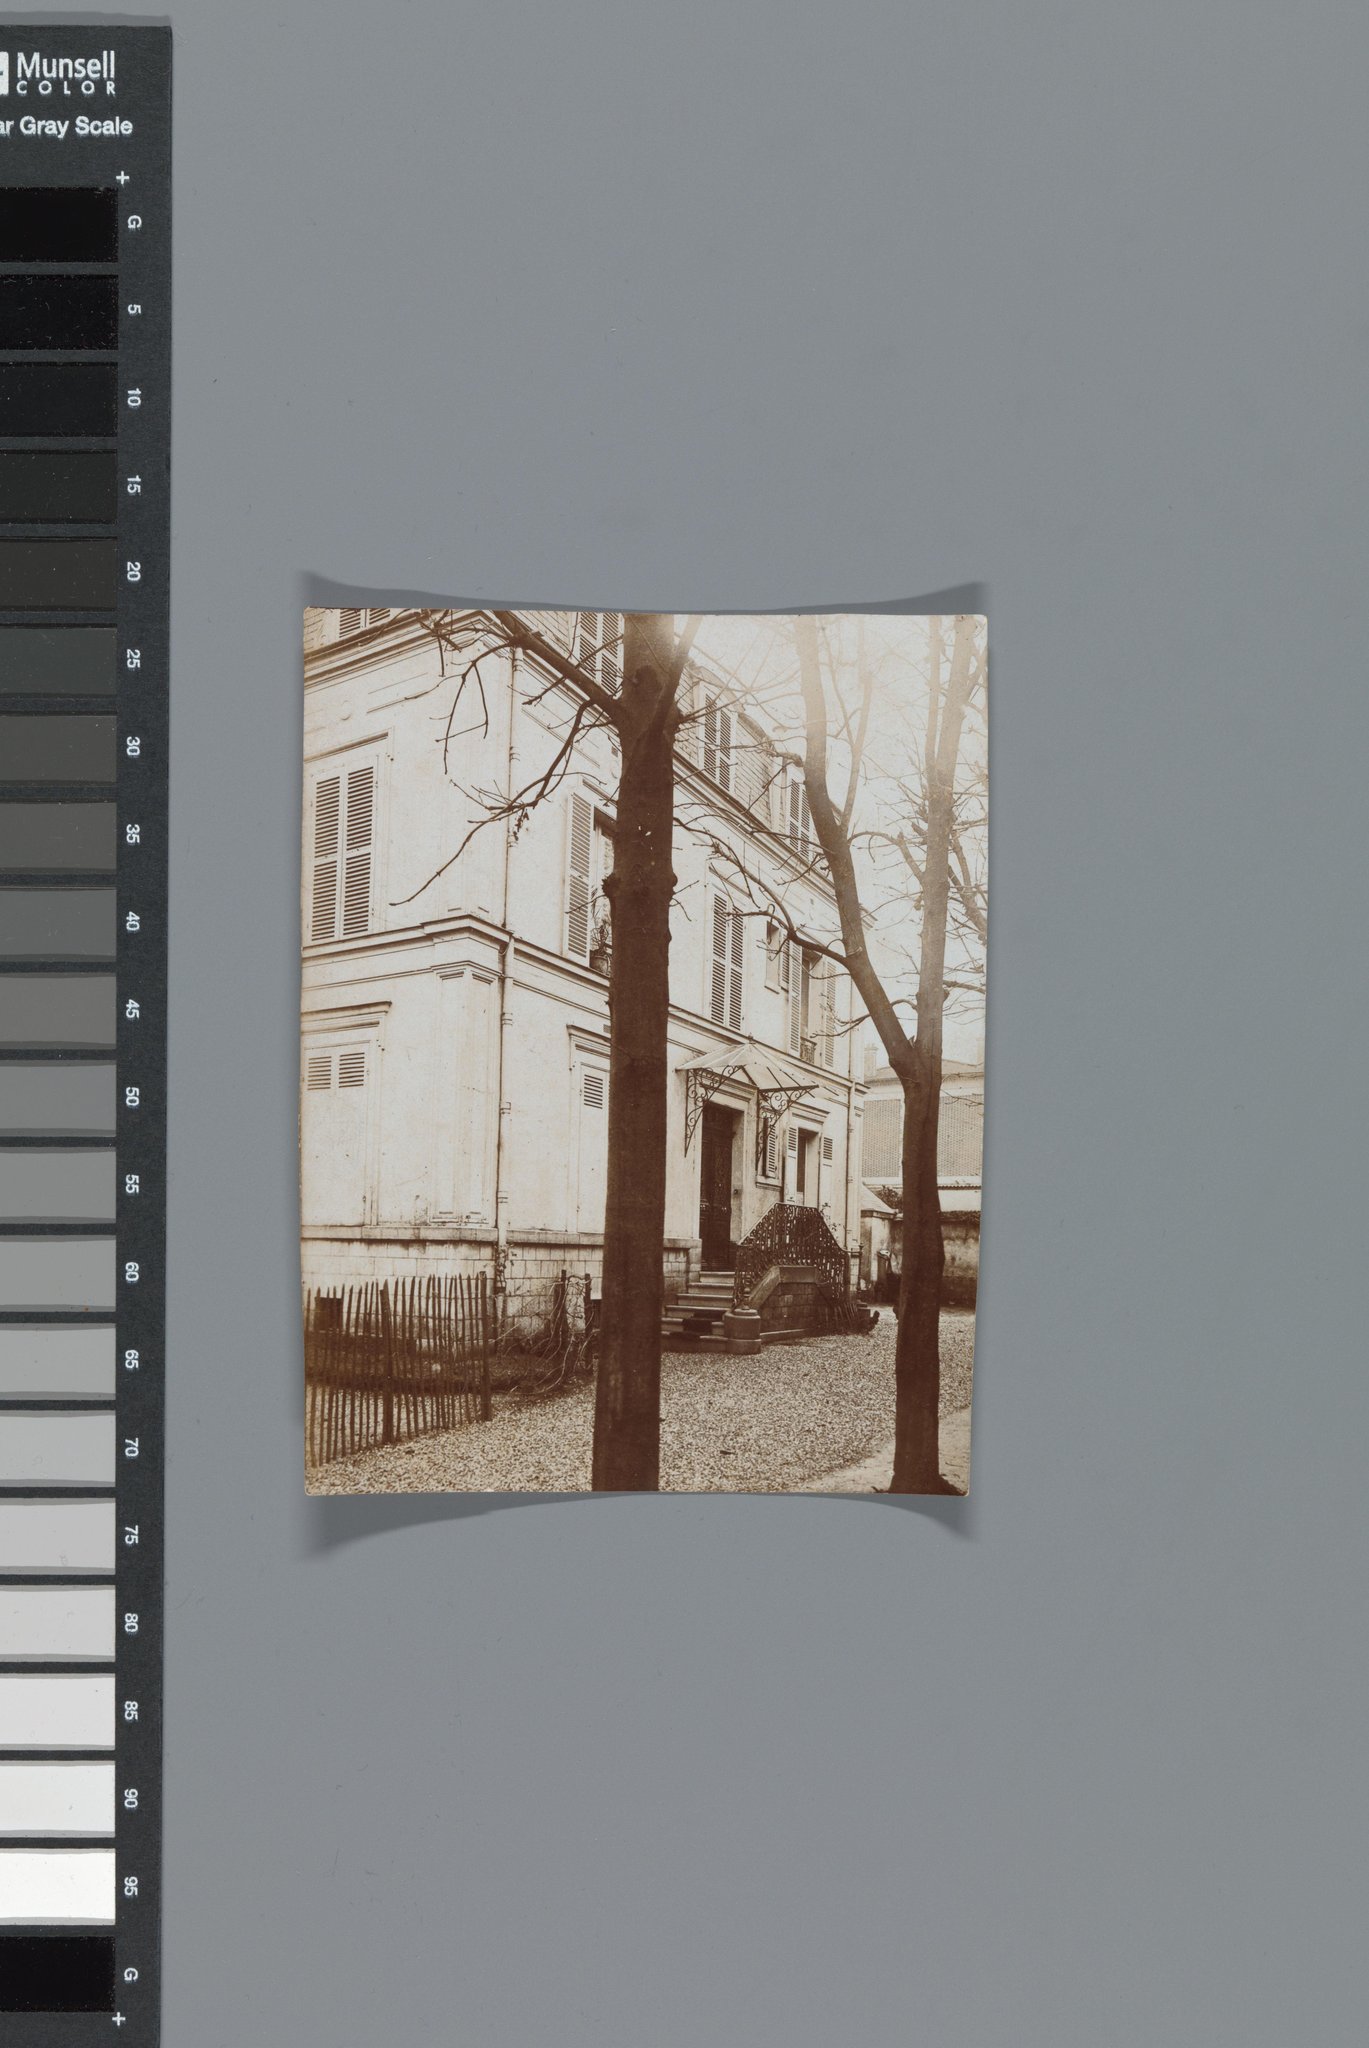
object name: photograph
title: Huis (Amsterdam)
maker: willem witsen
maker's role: draughtsman, painter, print maker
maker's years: 1860-1923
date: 1860-1915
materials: paper, photographic support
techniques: gelatin silver print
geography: amsterdam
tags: amsterdam